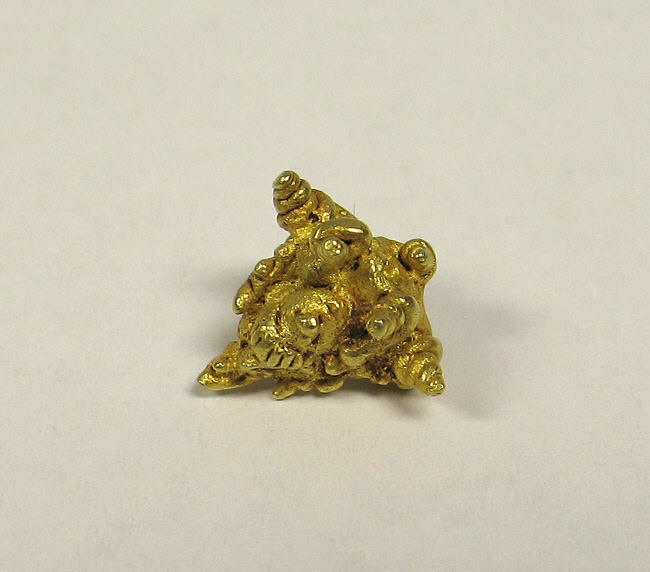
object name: ear ornament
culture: indonesian, central java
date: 701-1200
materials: gold